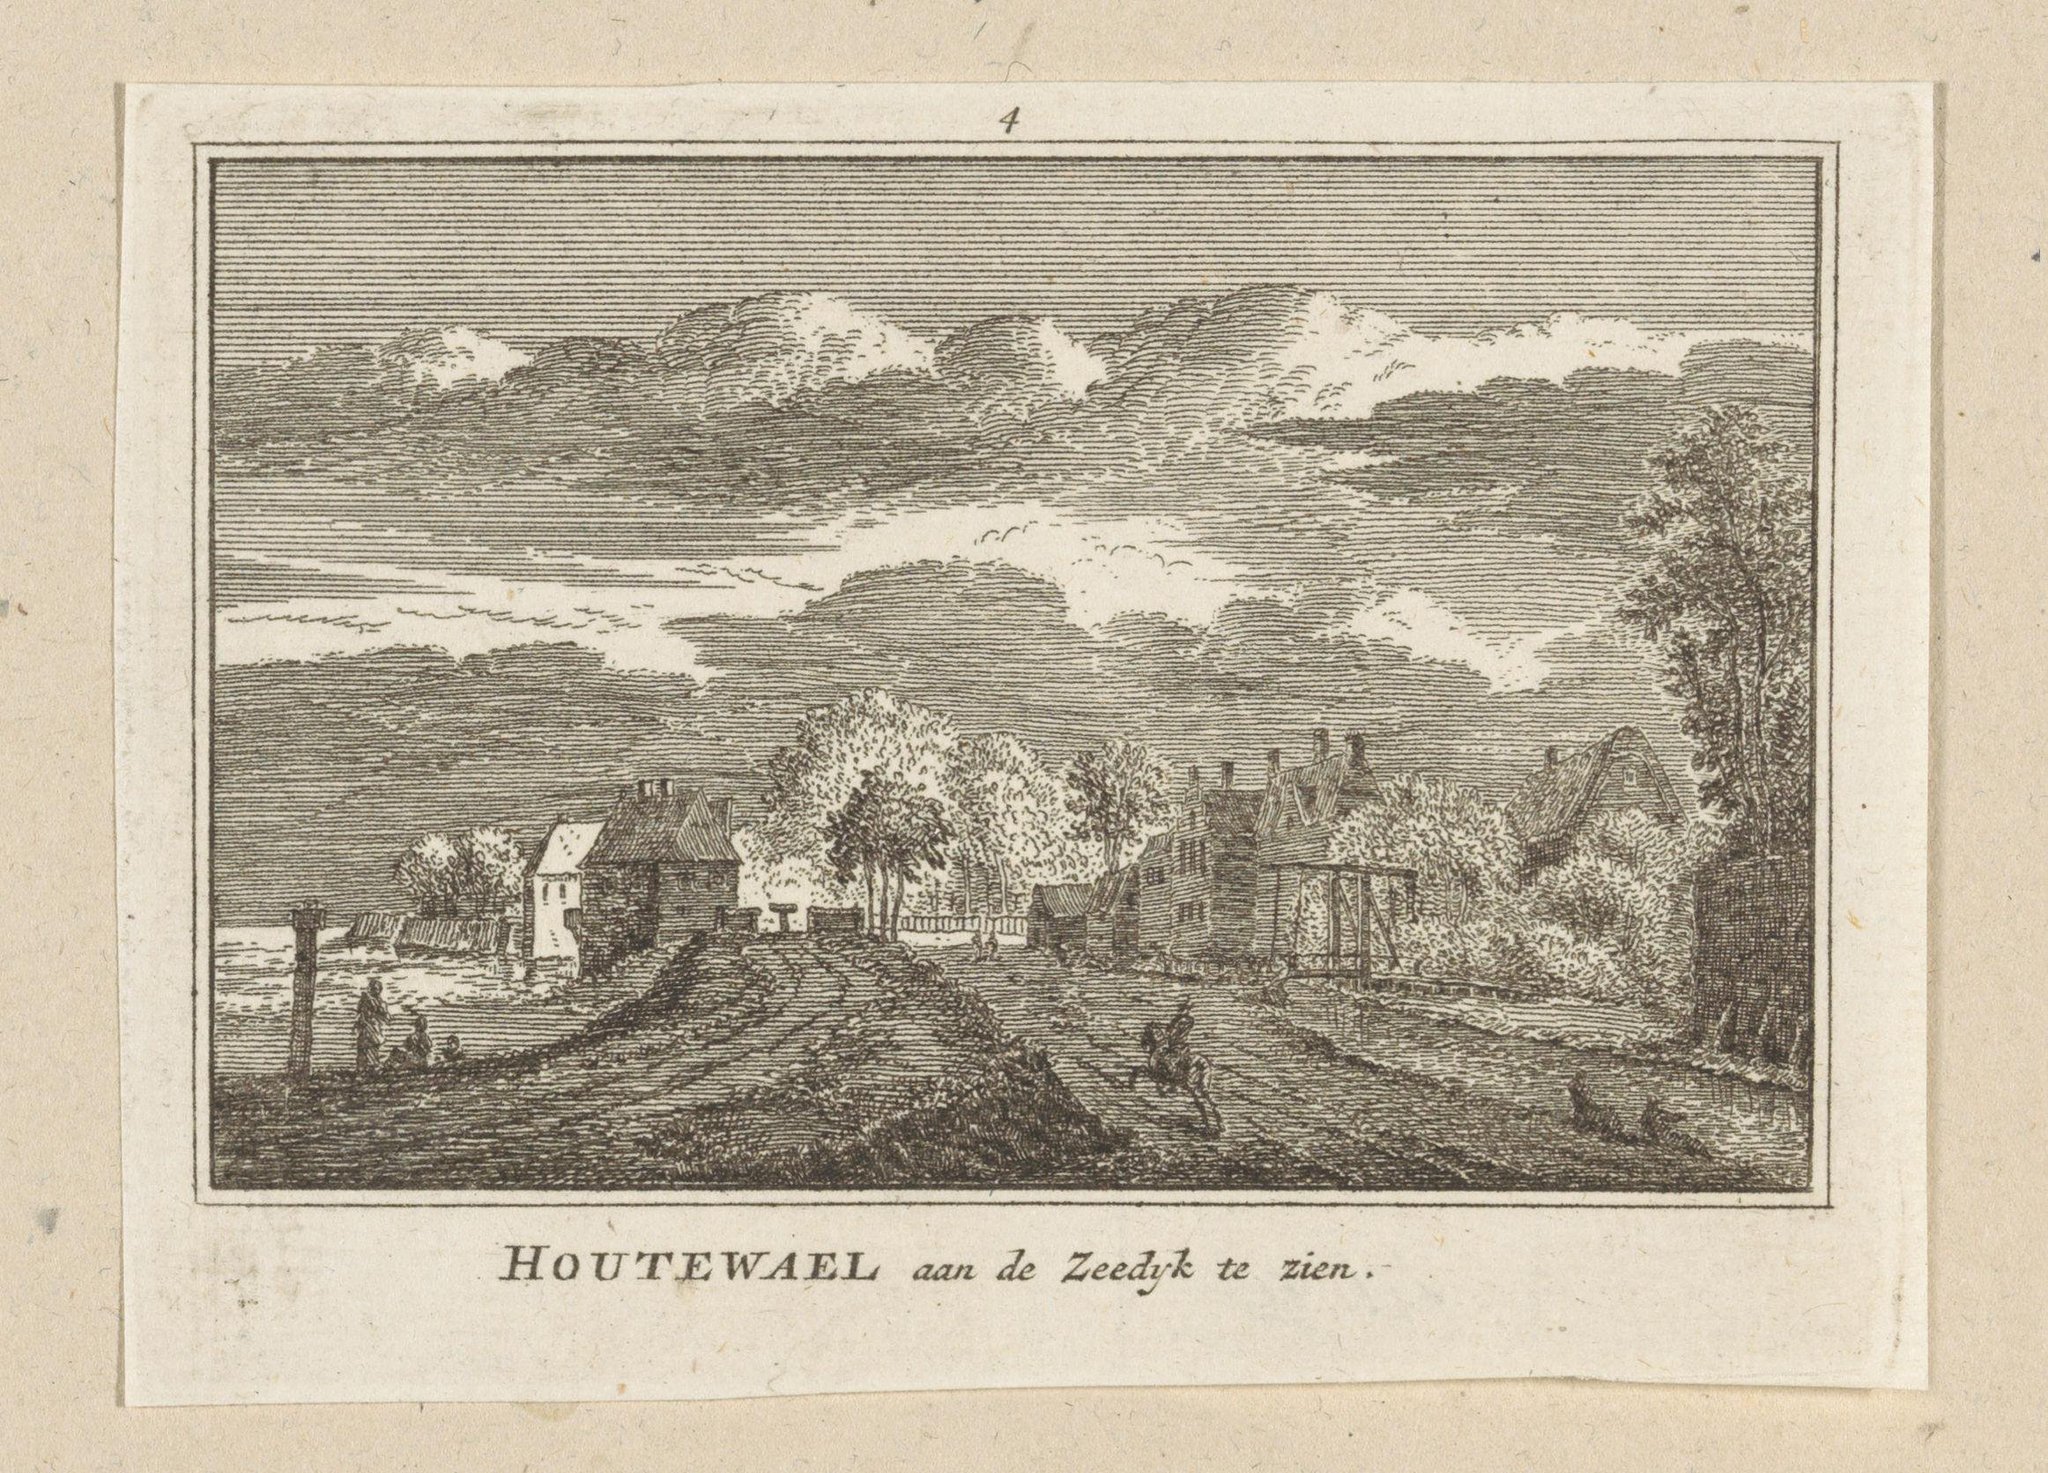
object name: book illustration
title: Houtewael aan de zeedyk te zien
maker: abraham rademaker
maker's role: draughtsman, print maker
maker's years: 1676-1735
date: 1725-1803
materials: paper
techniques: engraving, etching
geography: amsterdam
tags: prospect of village, silhouette of village, dikes, levee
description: Prent ook gebruikt in: Rademaker, Abraham. Kabinet van Nederlandsche outheden en gezichten: vervat in 300 konstplaaten (…). 2 delen. Amsterdam: Willem Barents, 1725, dl. 1, ill. 4. Na 1725 is deze prent nog in verschillende heruitgaven verschenen, uitgegeven in 1727-1733, 1770-1771 en 1792-1803. Uit welke uitgave het huidige exemplaar precies komt is niet na te gaan.